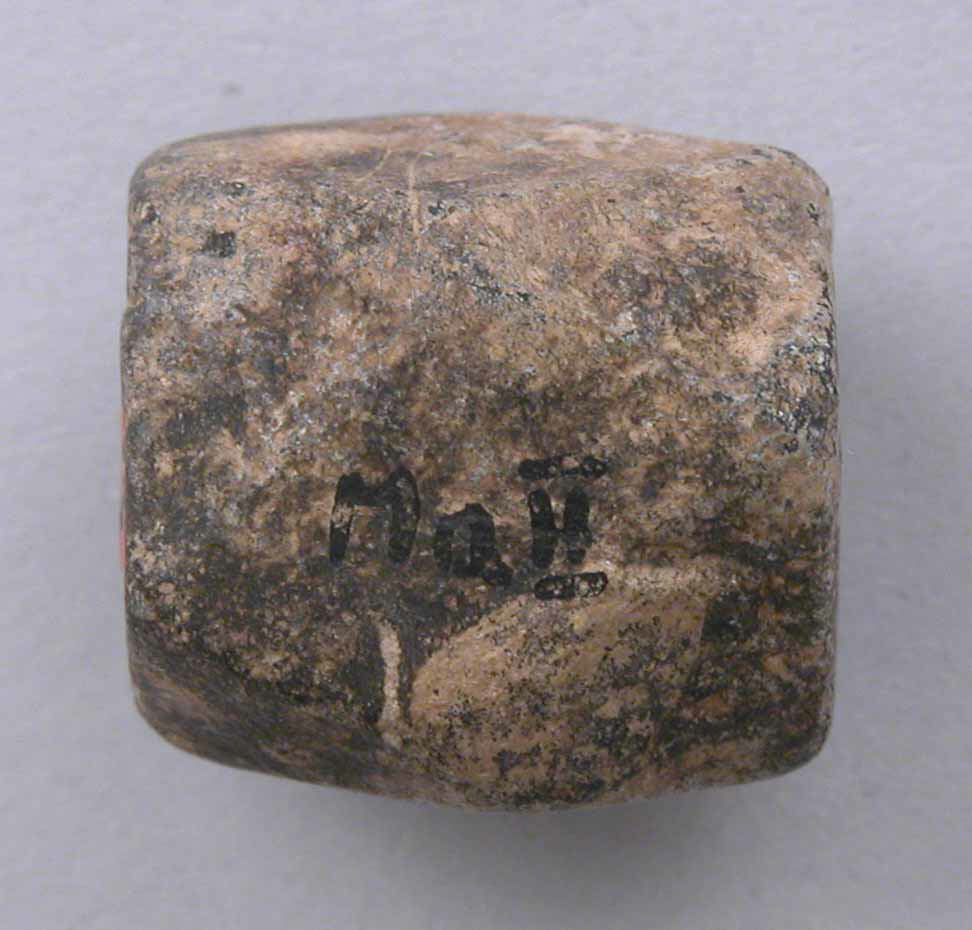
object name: bead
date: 601-800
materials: glass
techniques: glassblowing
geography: iraq